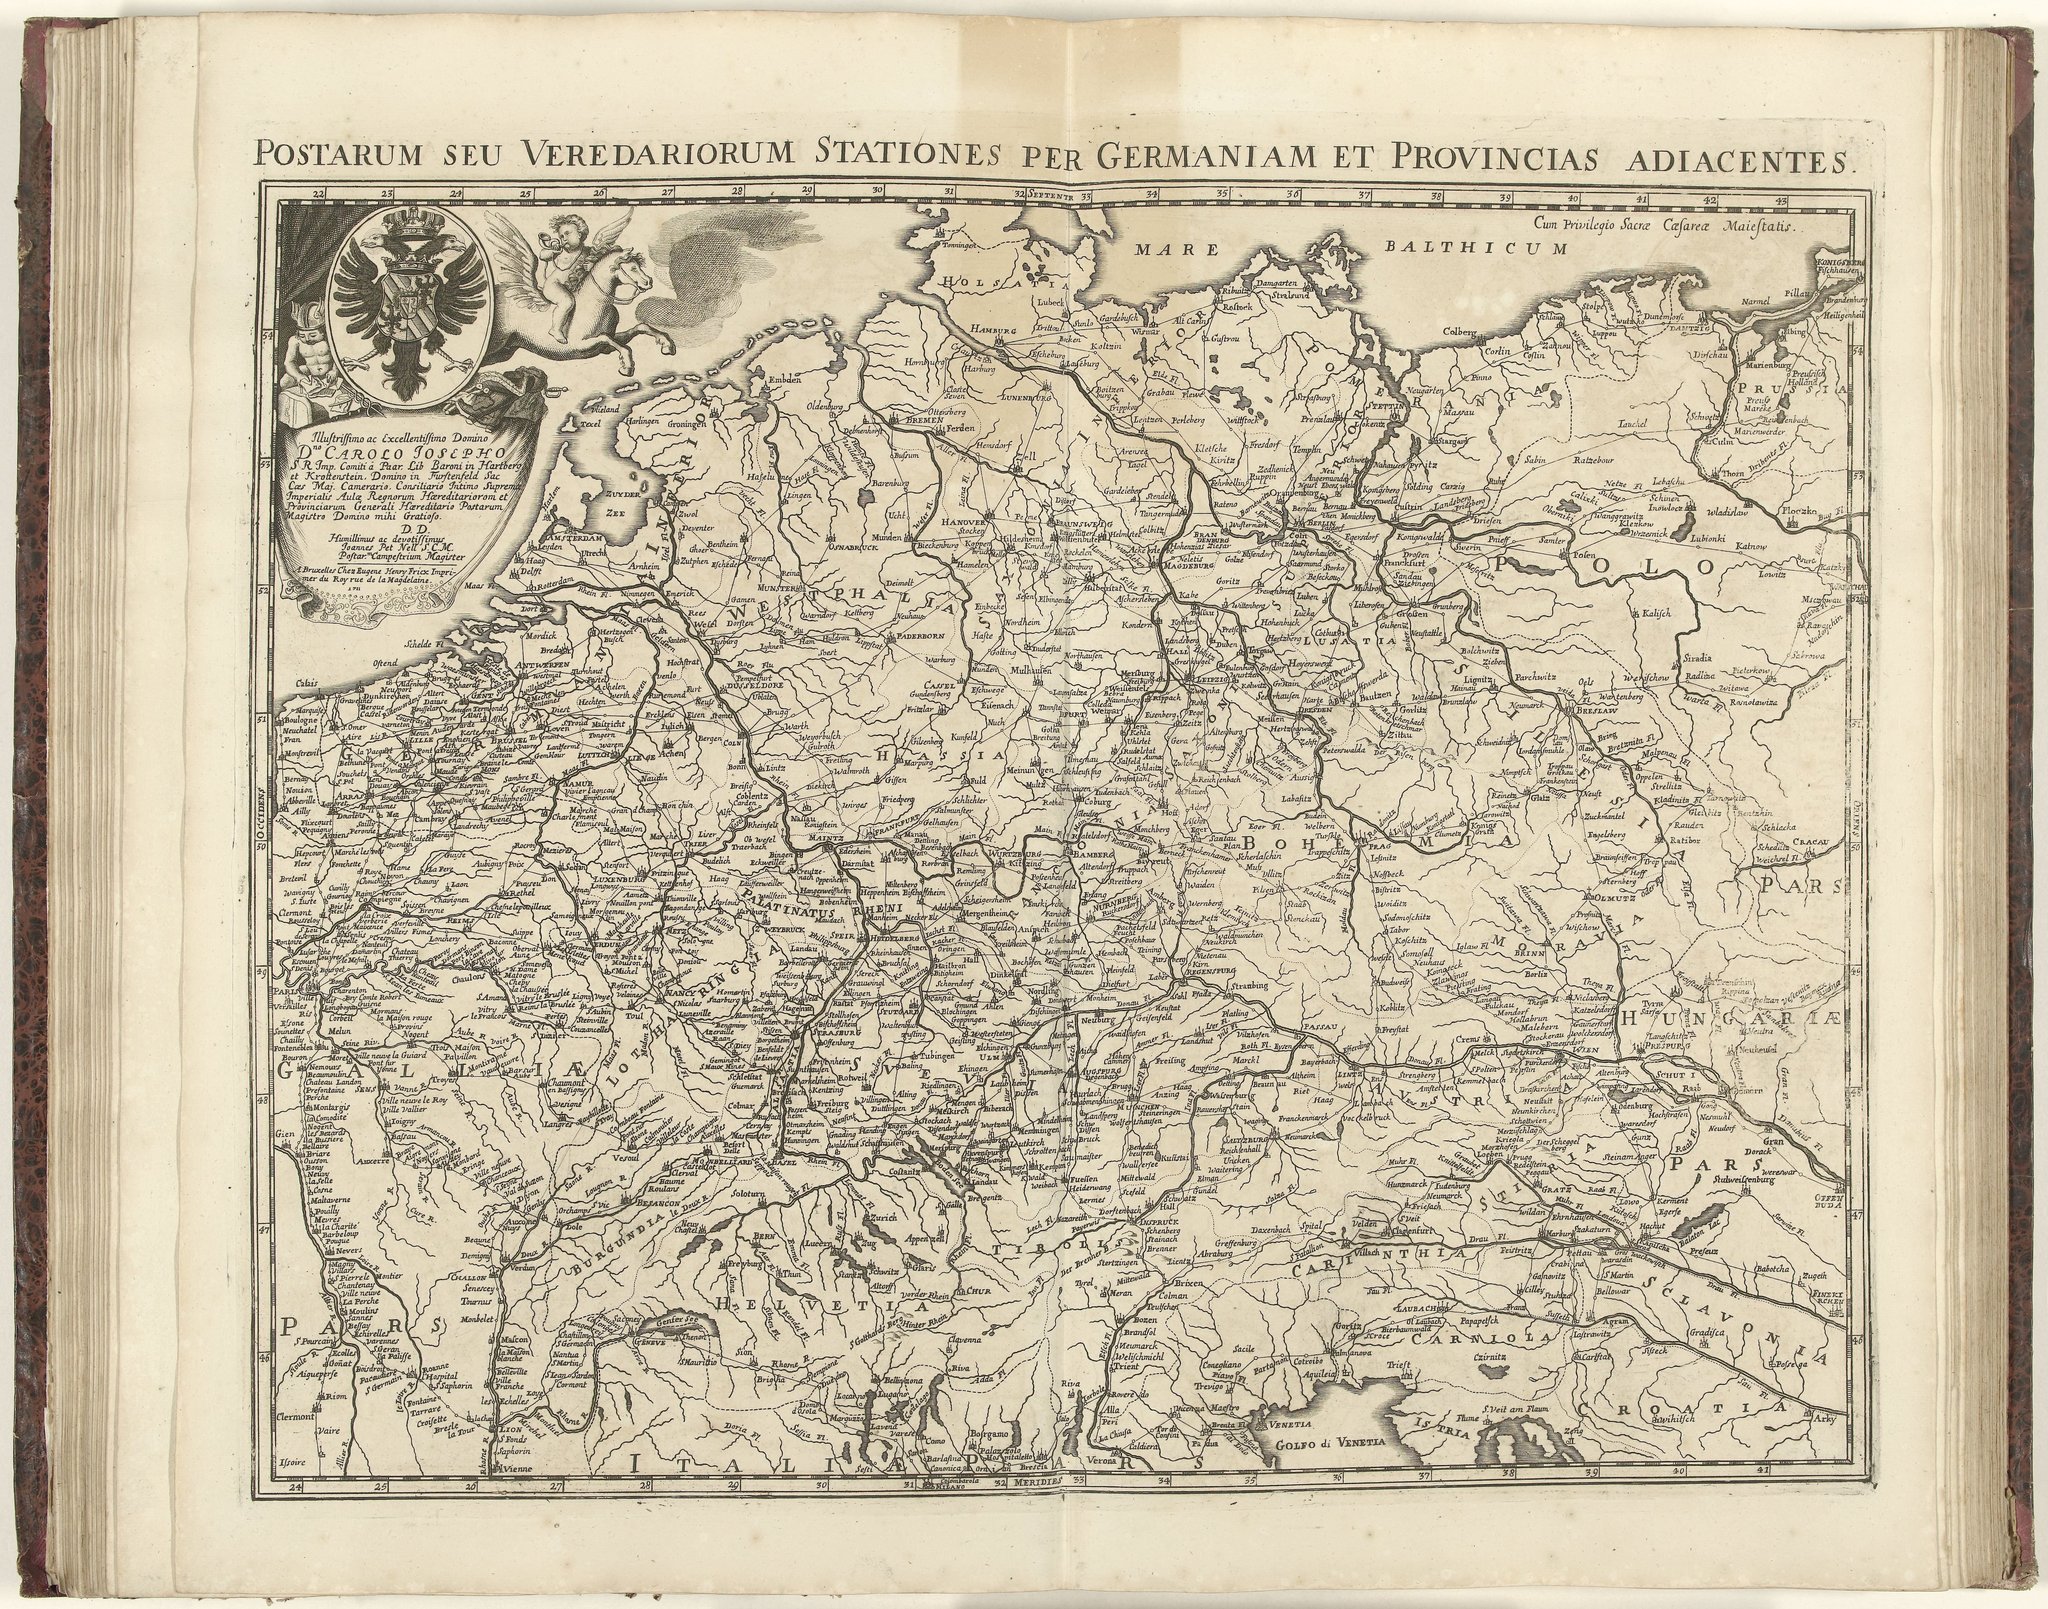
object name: print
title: Kaart van de postroutes door het Duitse Rijk, 1711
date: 1711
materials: paper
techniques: engraving, etching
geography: brussels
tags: postal service, maps of separate countries or regions, germany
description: Postkaart. Kaart van de postroutes door het Duitse Rijk en aangrenzende gebieden, 1711. Linksboven een cartouche met de opdracht van de keizerlijke hoofdpostmeester in het Latijn, hierbij een engel met posthoorn te paard en een briefschrijvende Mercurius. Onderdeel van een gebundelde verzameling van plannen van veldslagen en steden vermaard in de Spaanse Successieoorlog.